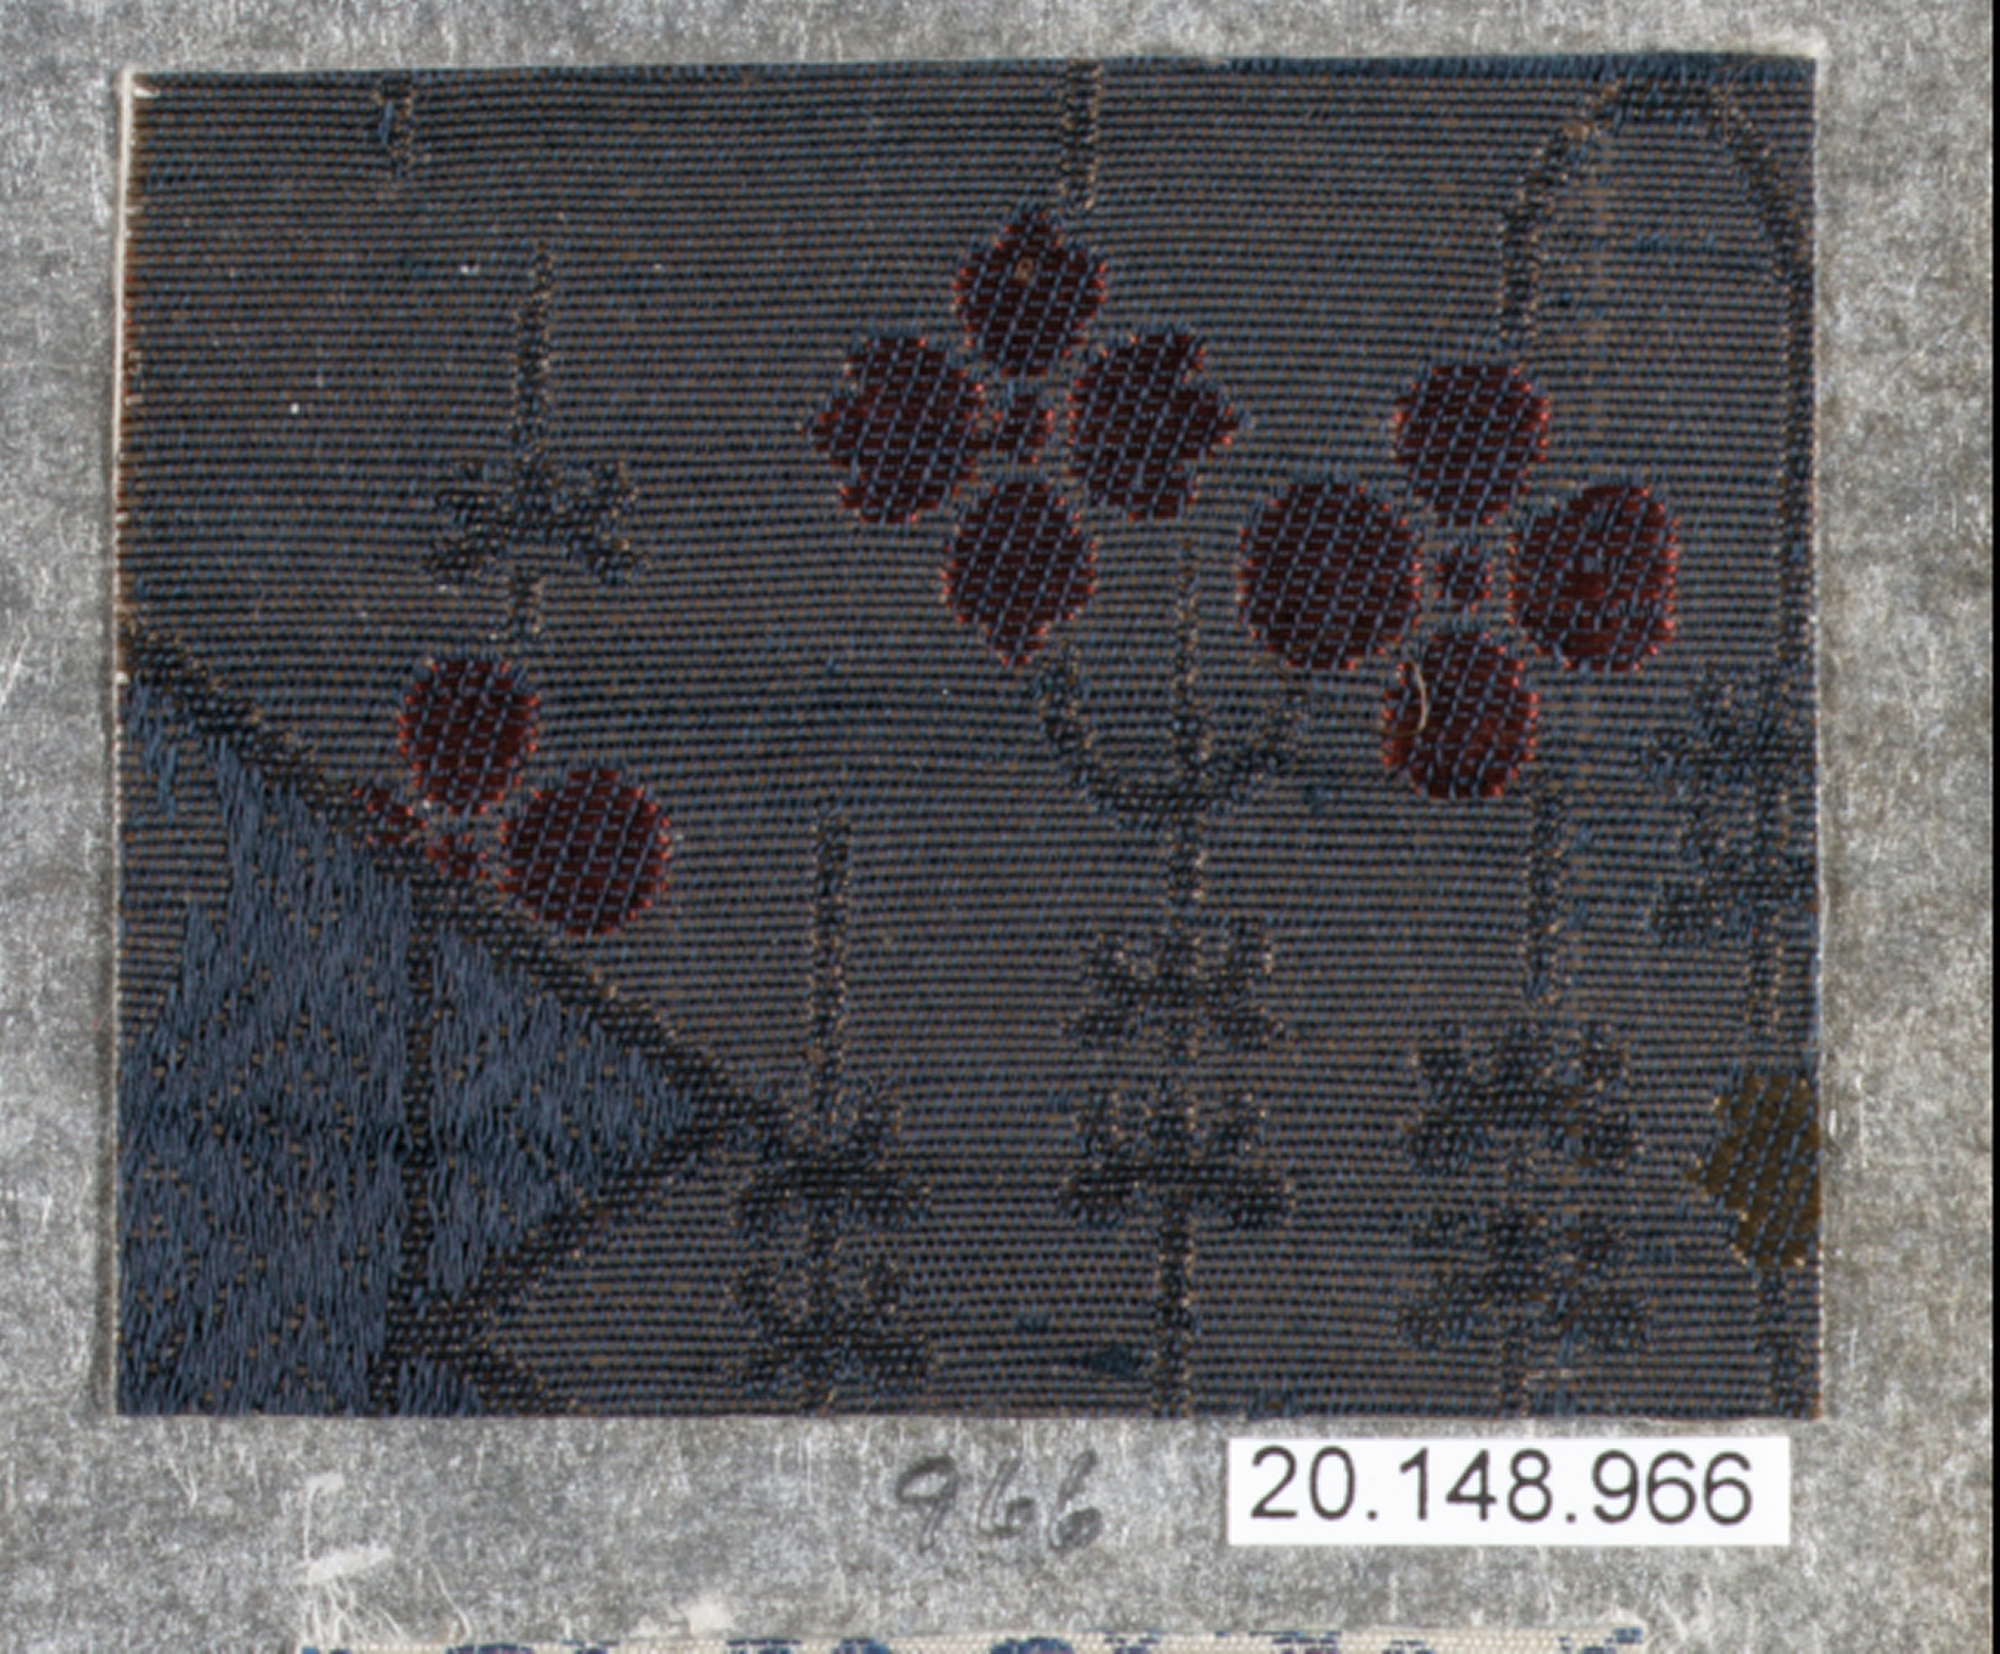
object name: piece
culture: japanese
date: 1701-1800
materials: silk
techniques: compound weave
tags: flowers